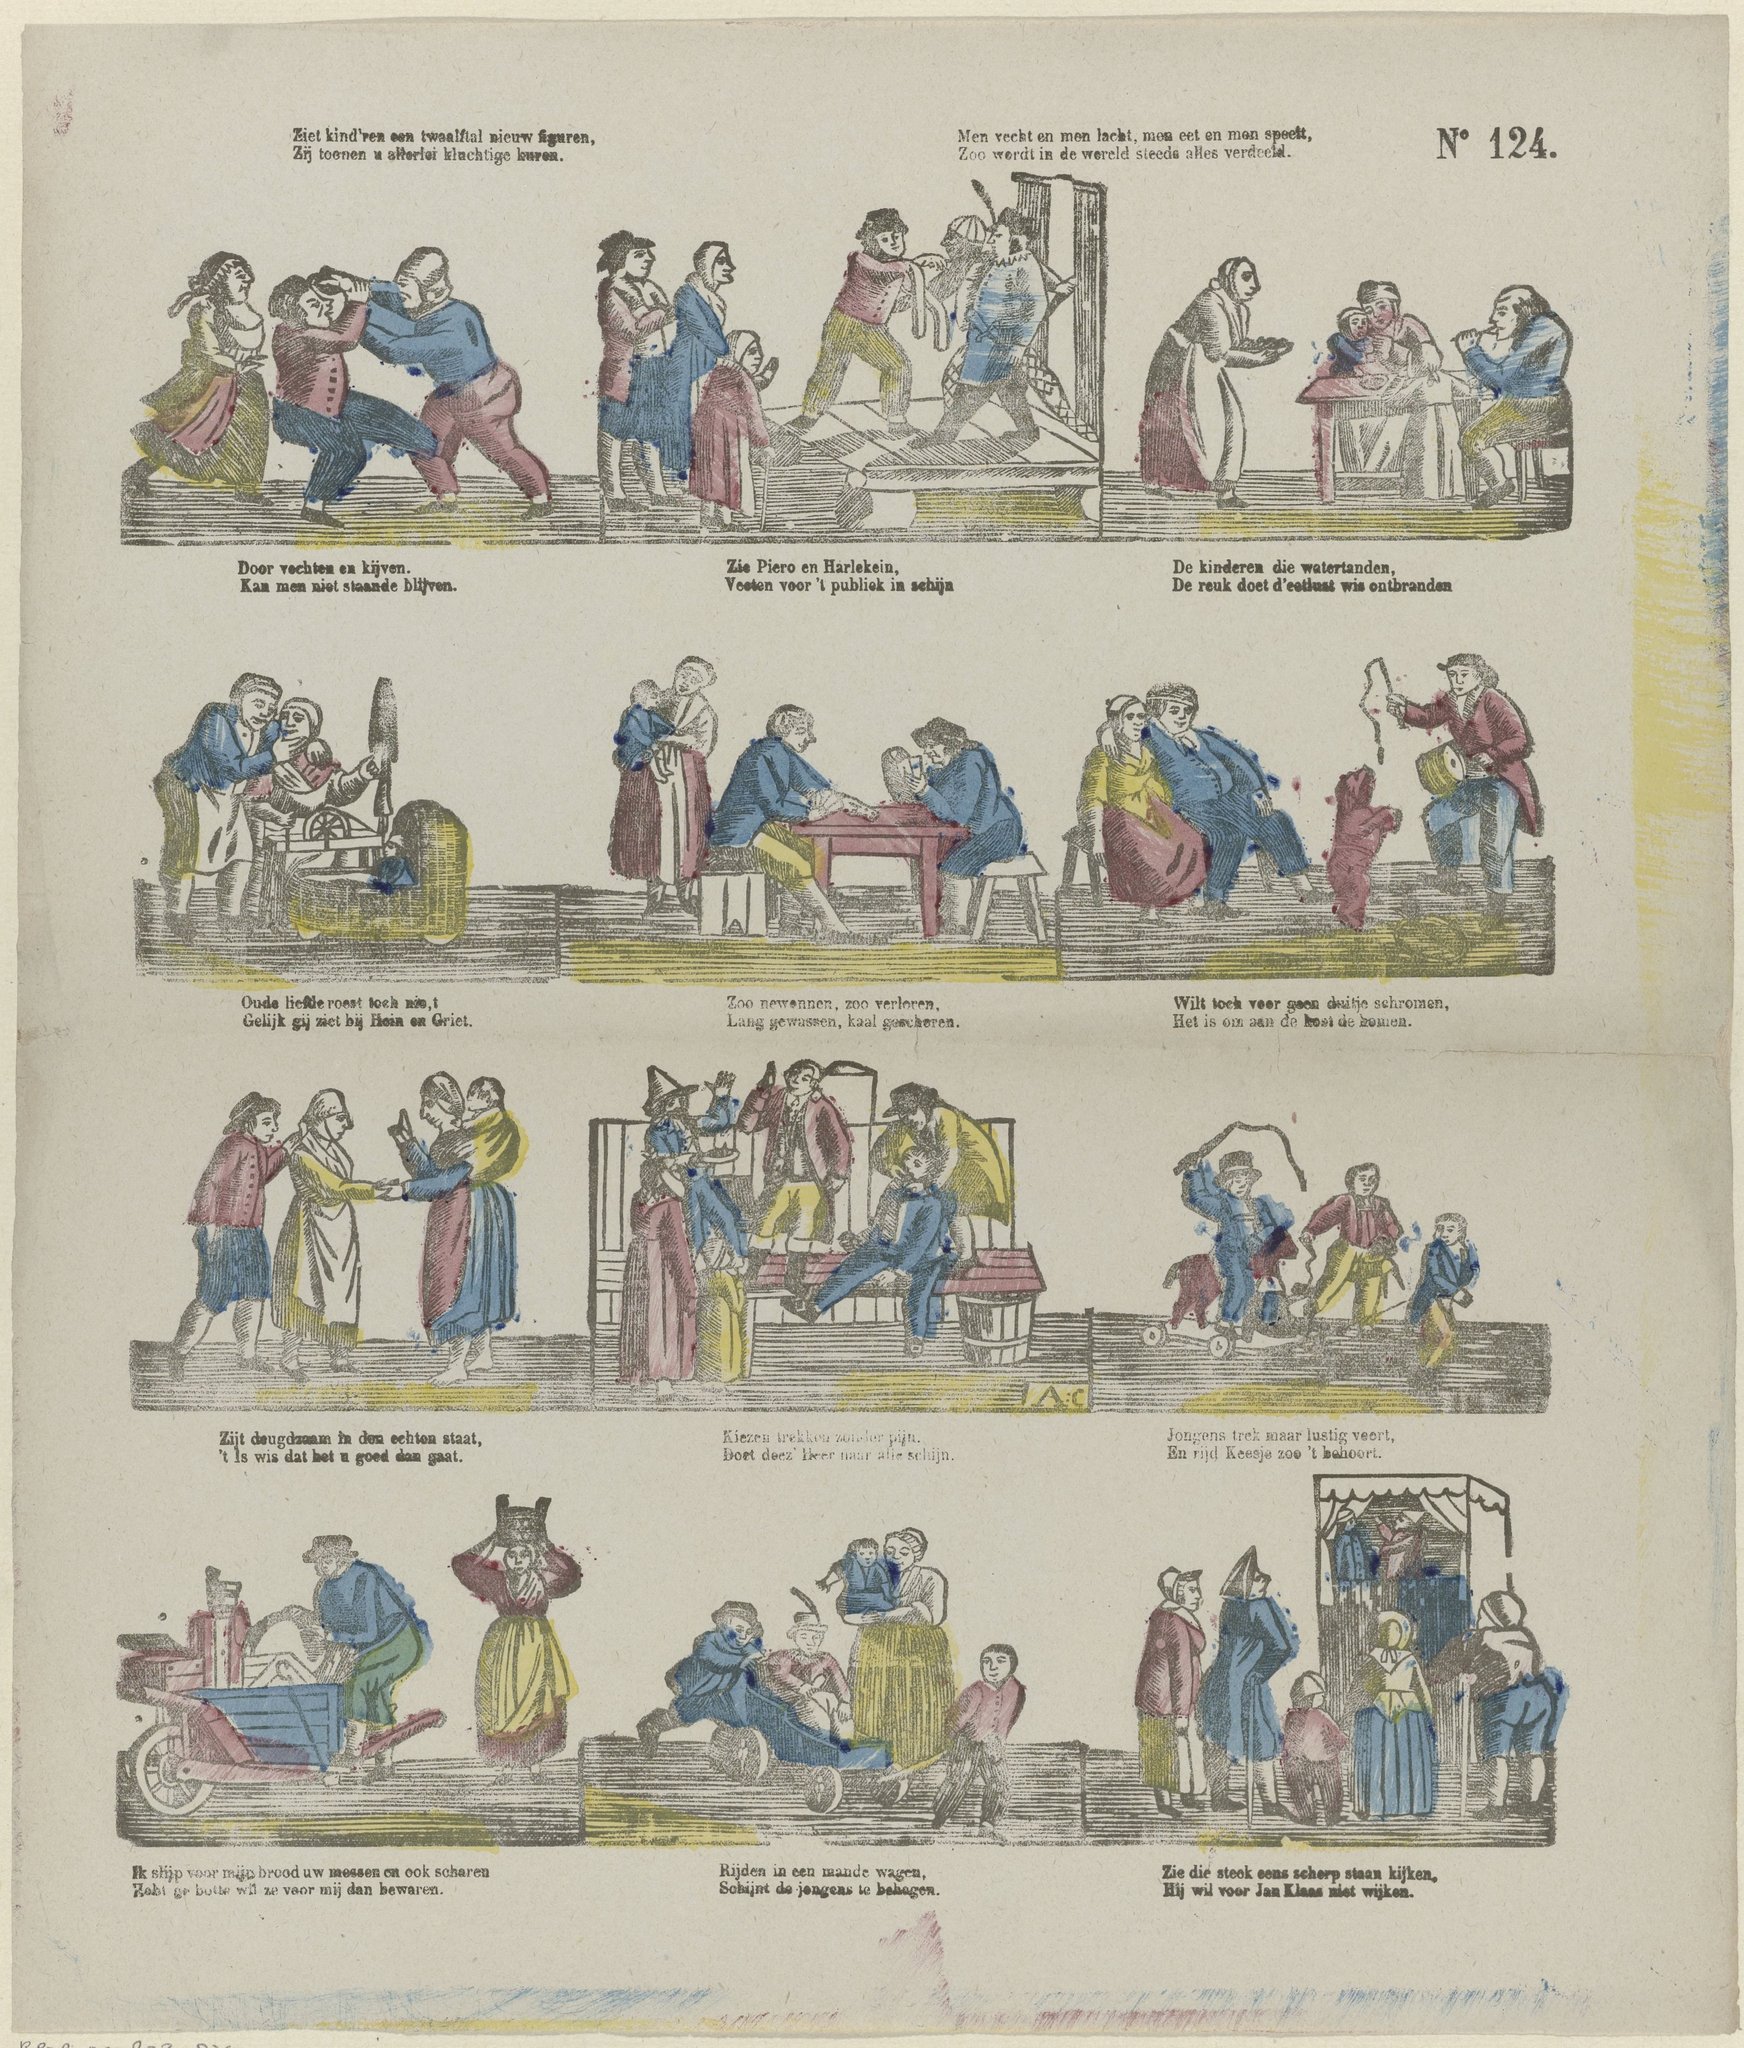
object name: print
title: Ziet kind'ren een twaalftal nieuw figuren, / Zij toonen u allerlei kluchtige kuren / Men vecht en men lacht, met eet en men speelt, / Zoo werdt in de weereld steeds alles verdeeld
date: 1827-1894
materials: paper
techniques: colour, letterpress printing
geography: schaarbeek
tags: proverbs, sayings, etc.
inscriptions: collector's mark: Lugt 2760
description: Blad met 12 verbeeldingen van spreekwoorden. Onder elke afbeelding een tweeregelig vers. Genummerd rechtsboven: No 124.